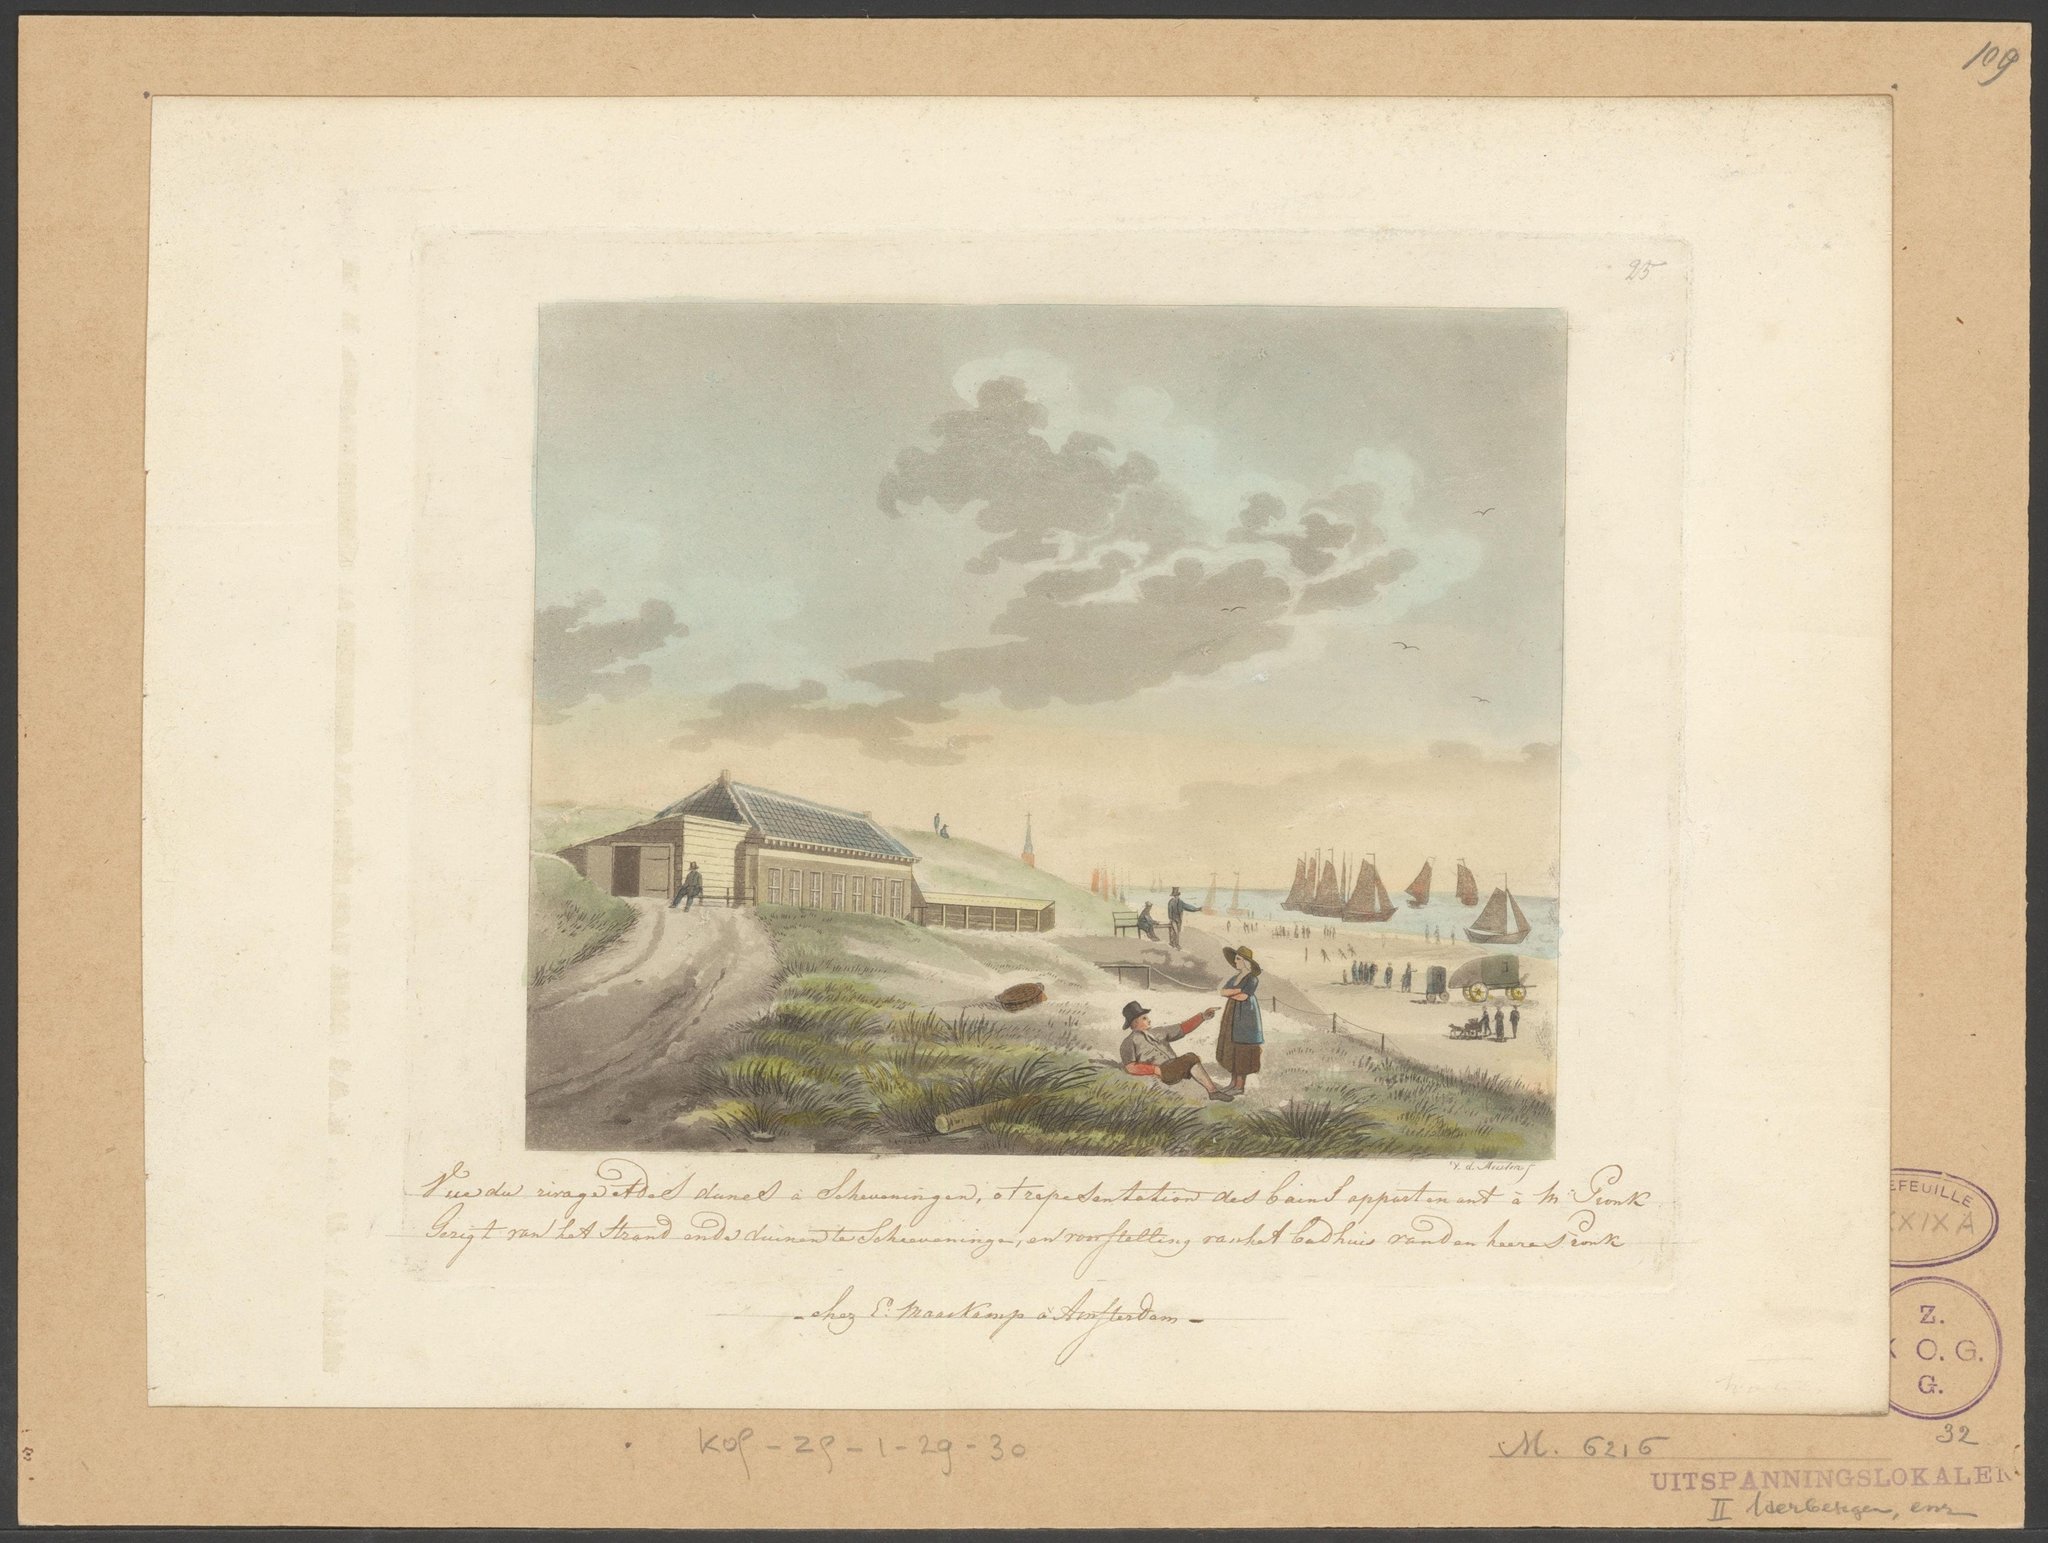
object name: print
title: Gezigt van het strand en de duinen te Scheveningen en Voorstelling van het badhuis van den heer Pronk / Vue du rivage et des dunes a Scheveninge et representation des Bains appartement à mons.r Pronk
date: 1824-1830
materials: paper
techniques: aquatint, etching, hand coloring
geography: amsterdam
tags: beach (as place of recreation)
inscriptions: collector's mark: Lugt 1641, stamp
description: Gezicht op de duinen en het strand bij Scheveningen en het badhuis van de heer Pronk, ca. 1825. Onderdeel van een plaatwerk uit ca. 1824-1825 met 74 (ongenummerde) platen van de belangrijkste topografische gezichten en verschillende zeden en gewoonten in het Verenigd Koninkrijk der Nederlanden. Onderwerpsrubrieken binnen de Atlas Zeden en Gewoonten: Zeden en gewoonten in engeren zin, Volksleven, Uitspanningslokalen, Badhuizen.